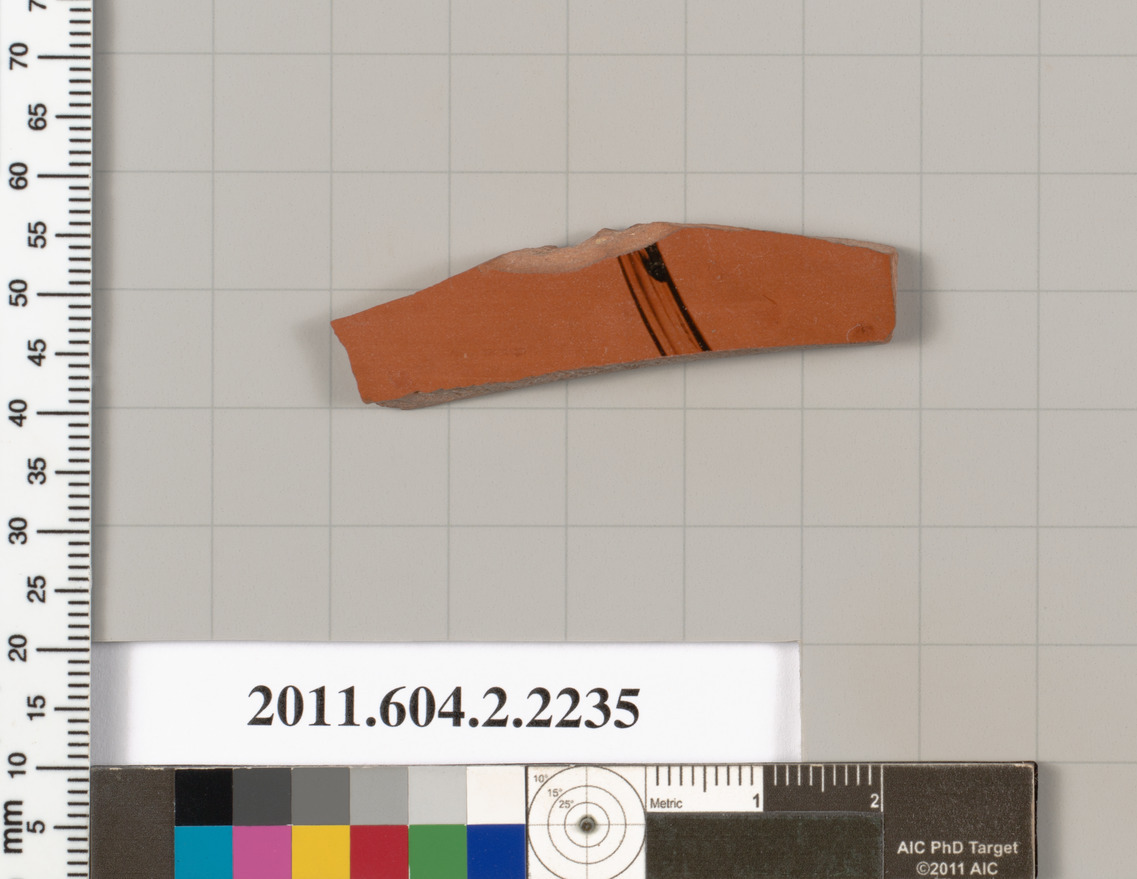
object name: pot fragment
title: Terracotta fragment of a pot; unglazed on the inside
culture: greek, attic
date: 460-440 BCE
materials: terracotta